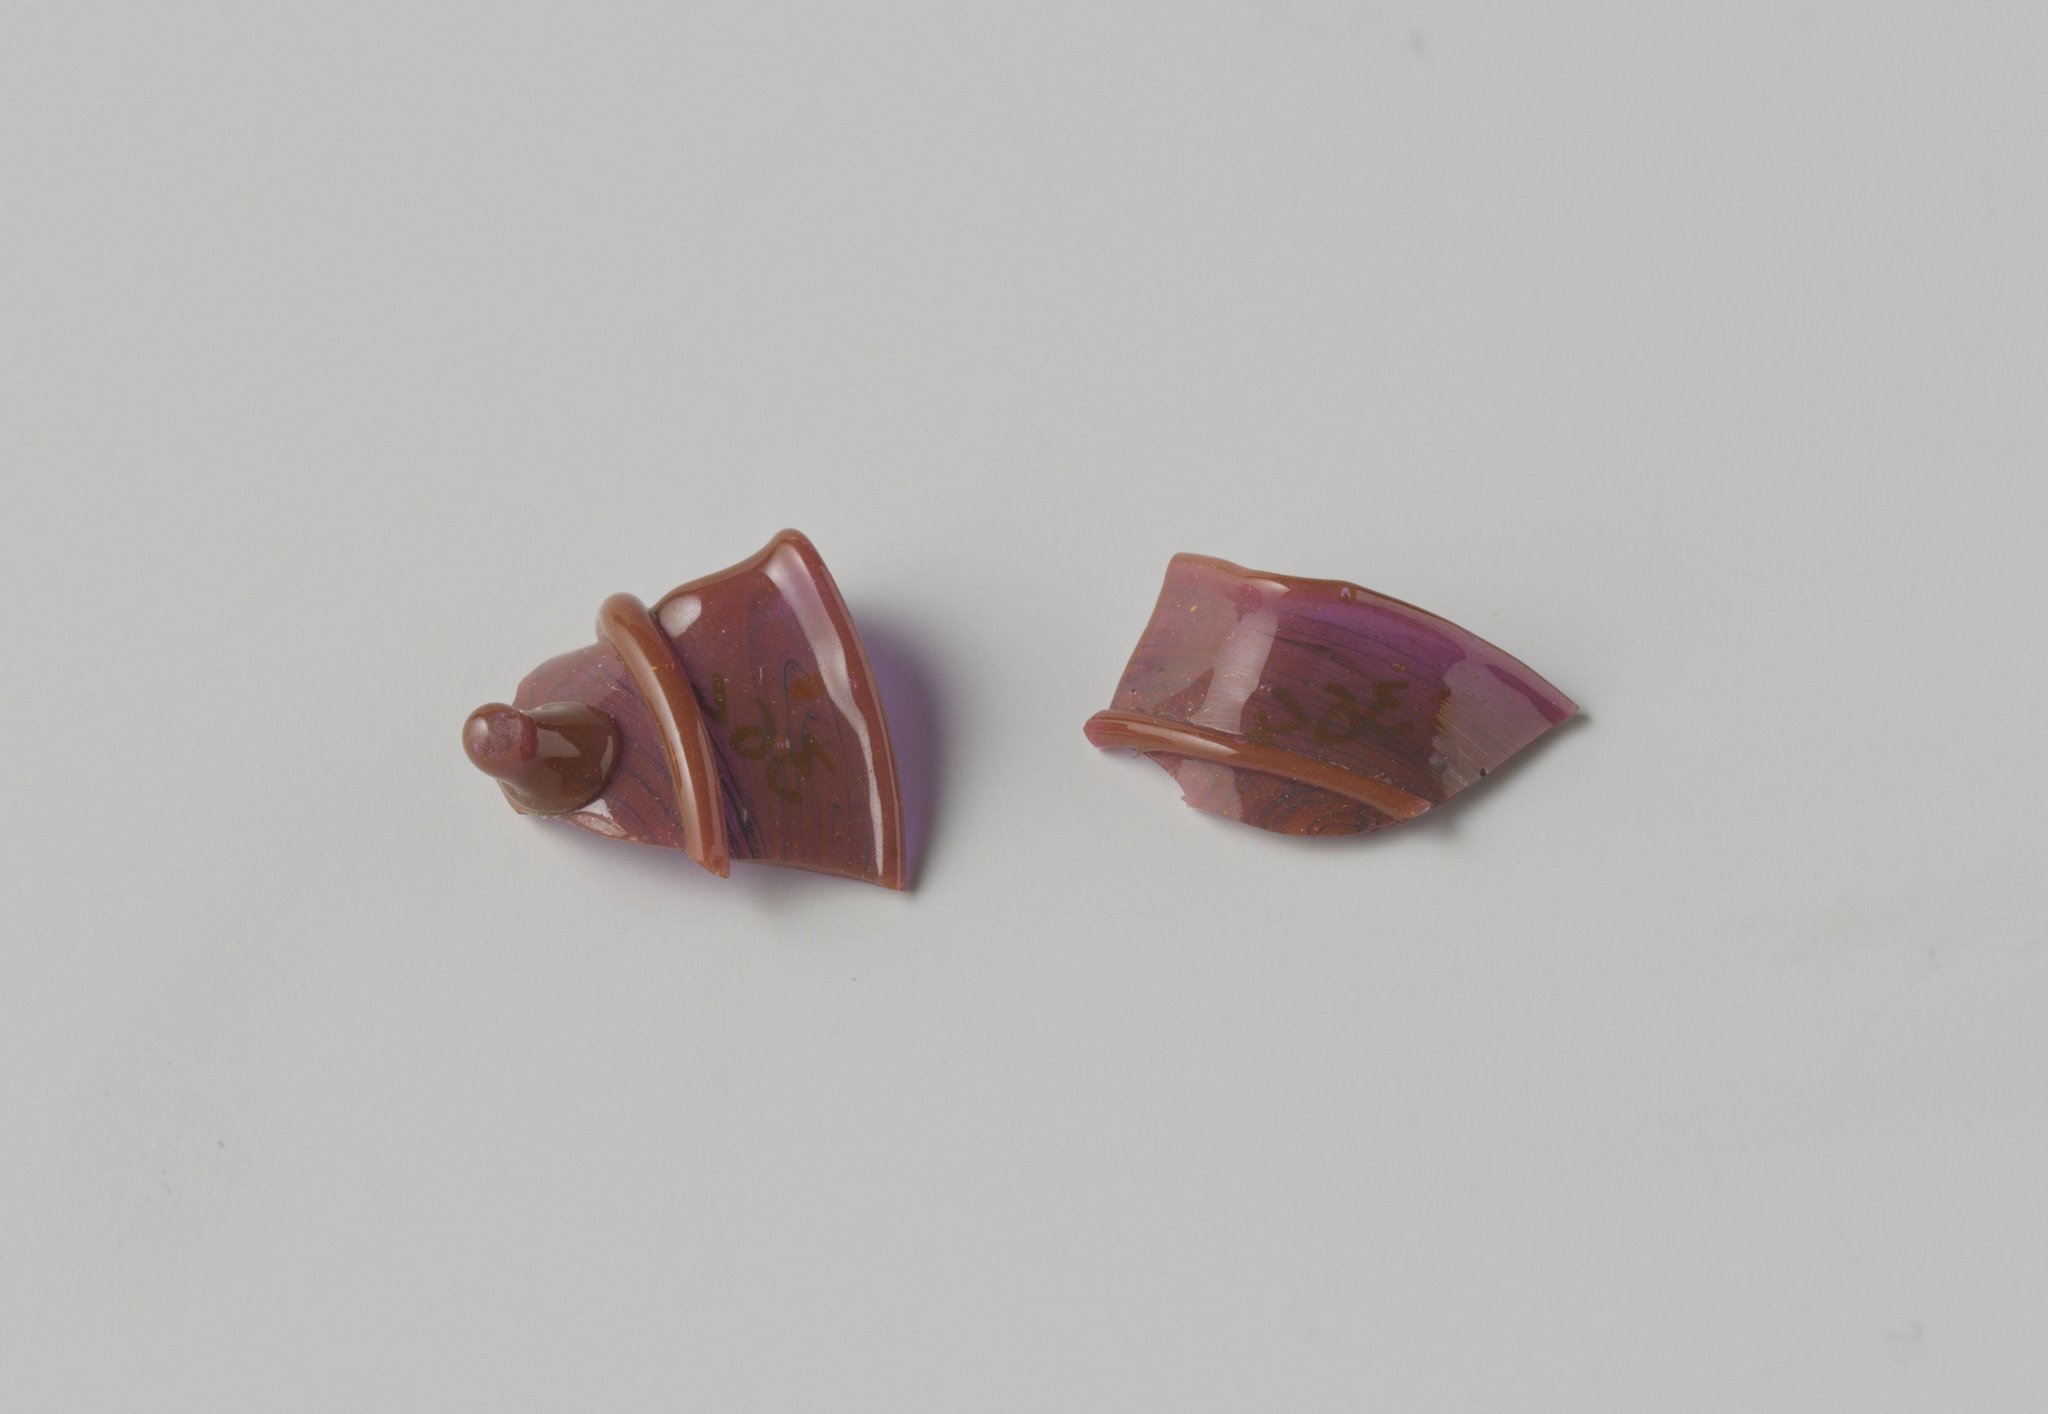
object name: drinking glass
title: Scherf van bruinpaars glas; rest van een vuurtest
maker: Anonymous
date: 1675-1710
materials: glass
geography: amsterdam